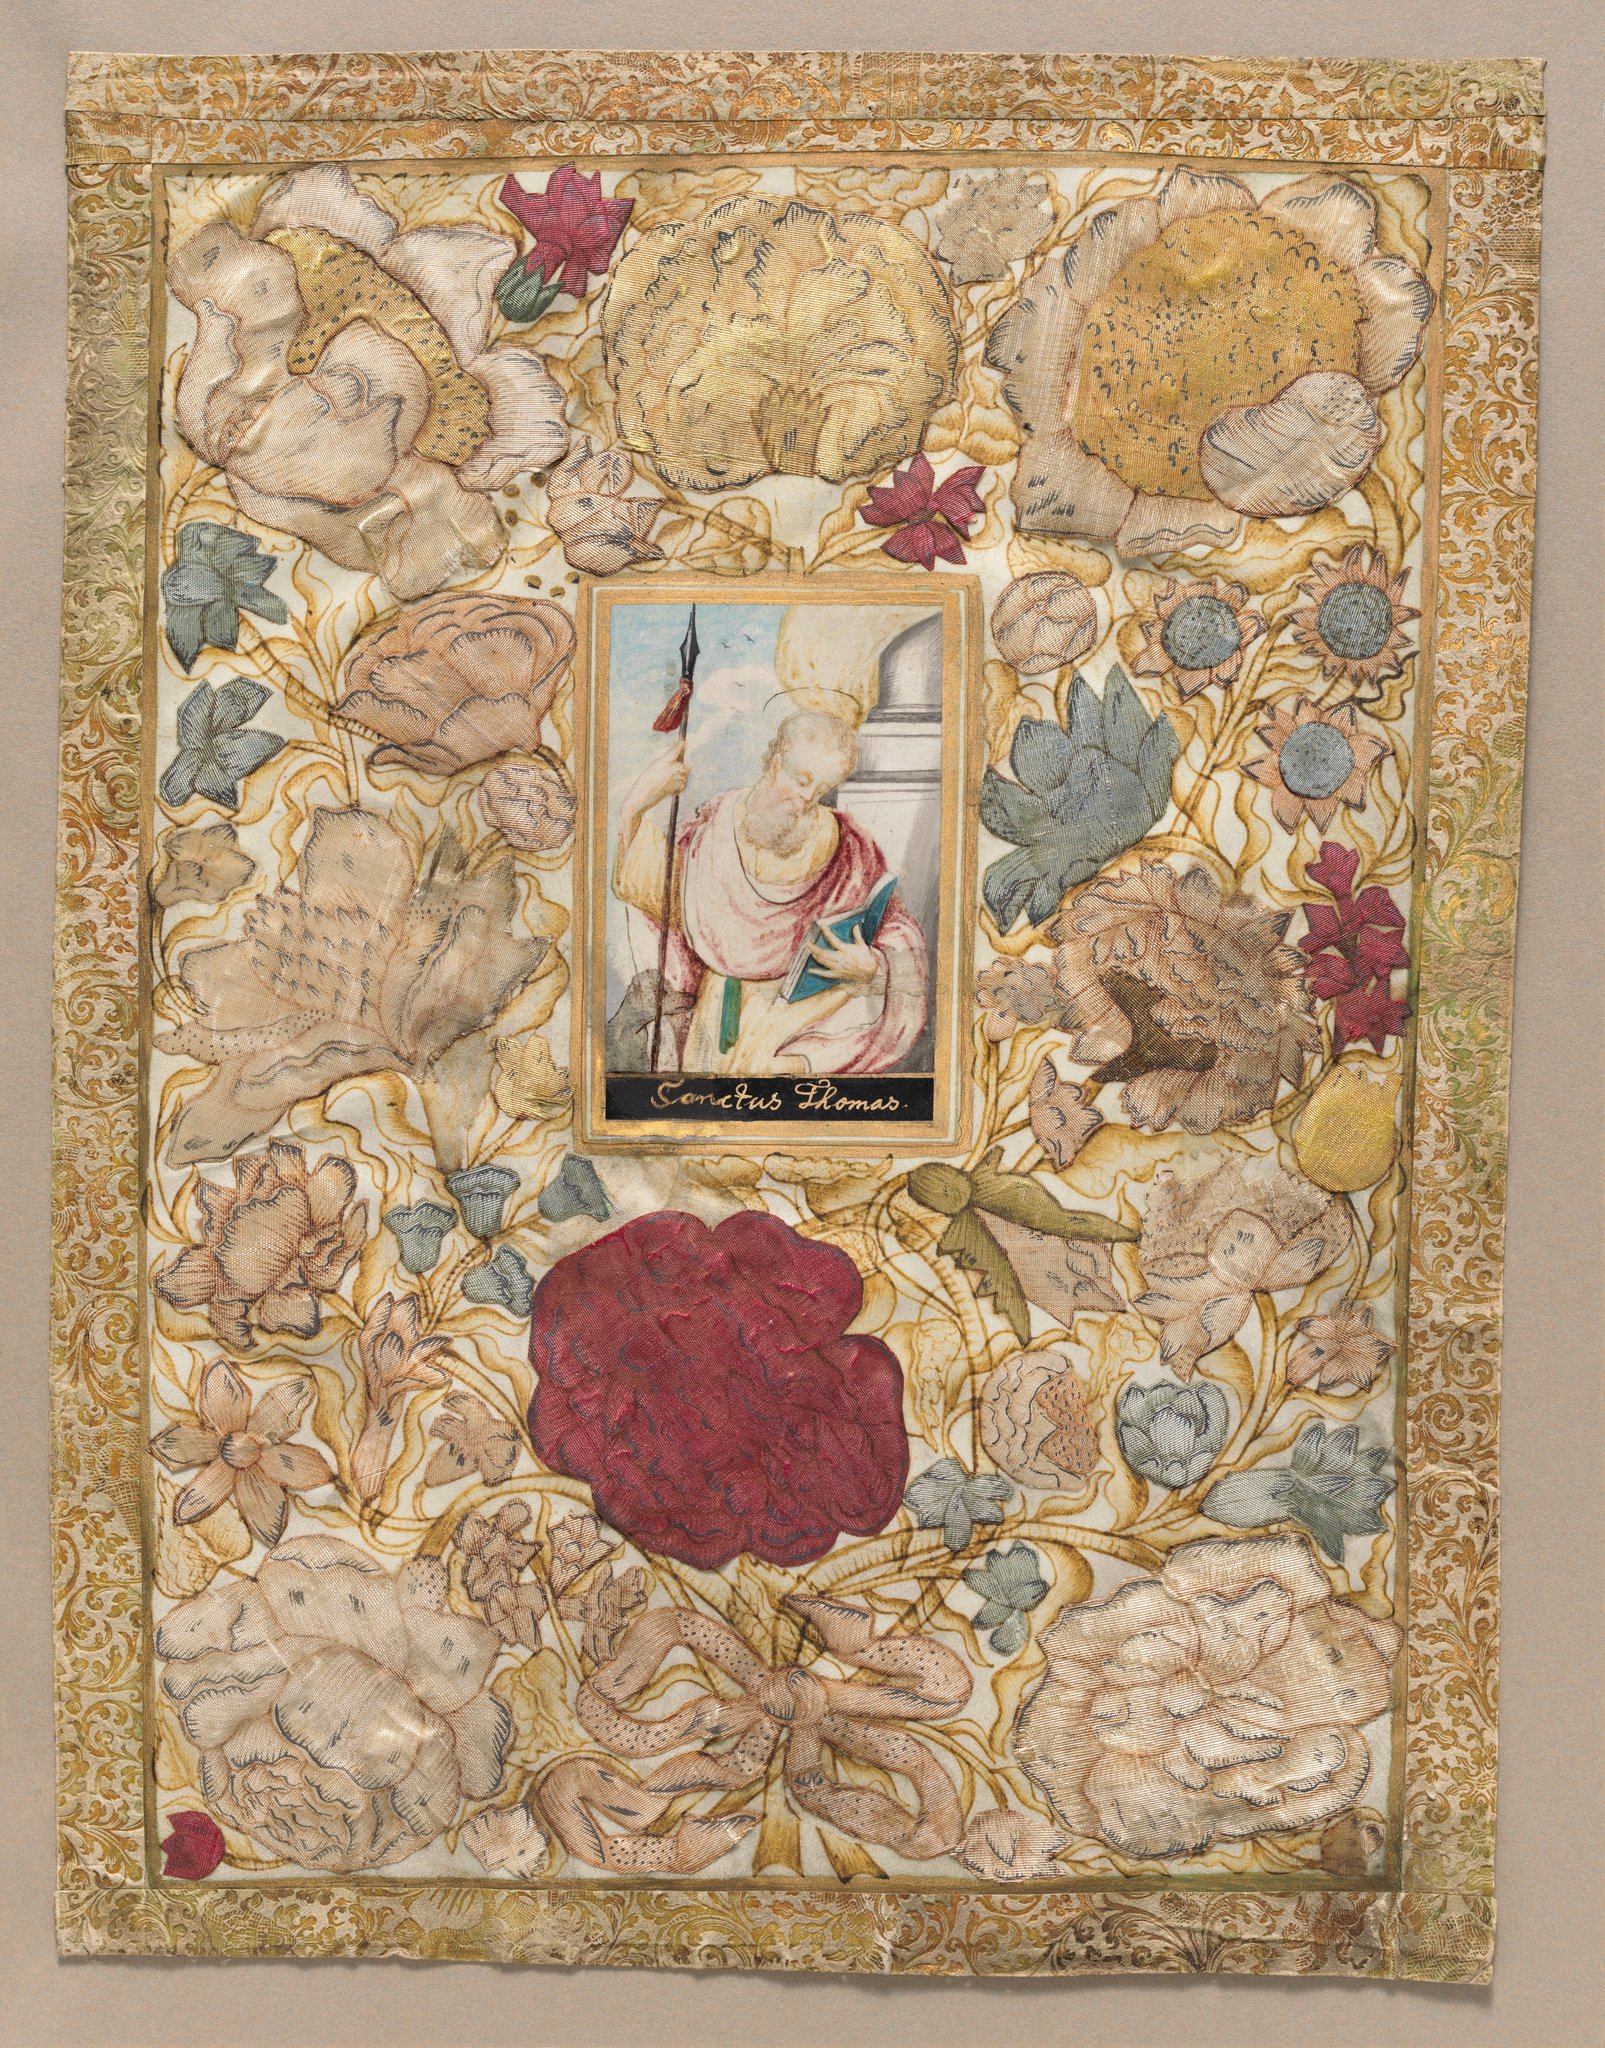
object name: cut paper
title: Saint Thomas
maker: anonymous, german, 18th century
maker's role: artist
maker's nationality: german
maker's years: 1700-1800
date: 1701-1800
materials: gilt, ink, paper, silk, parchment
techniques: painting, stamping